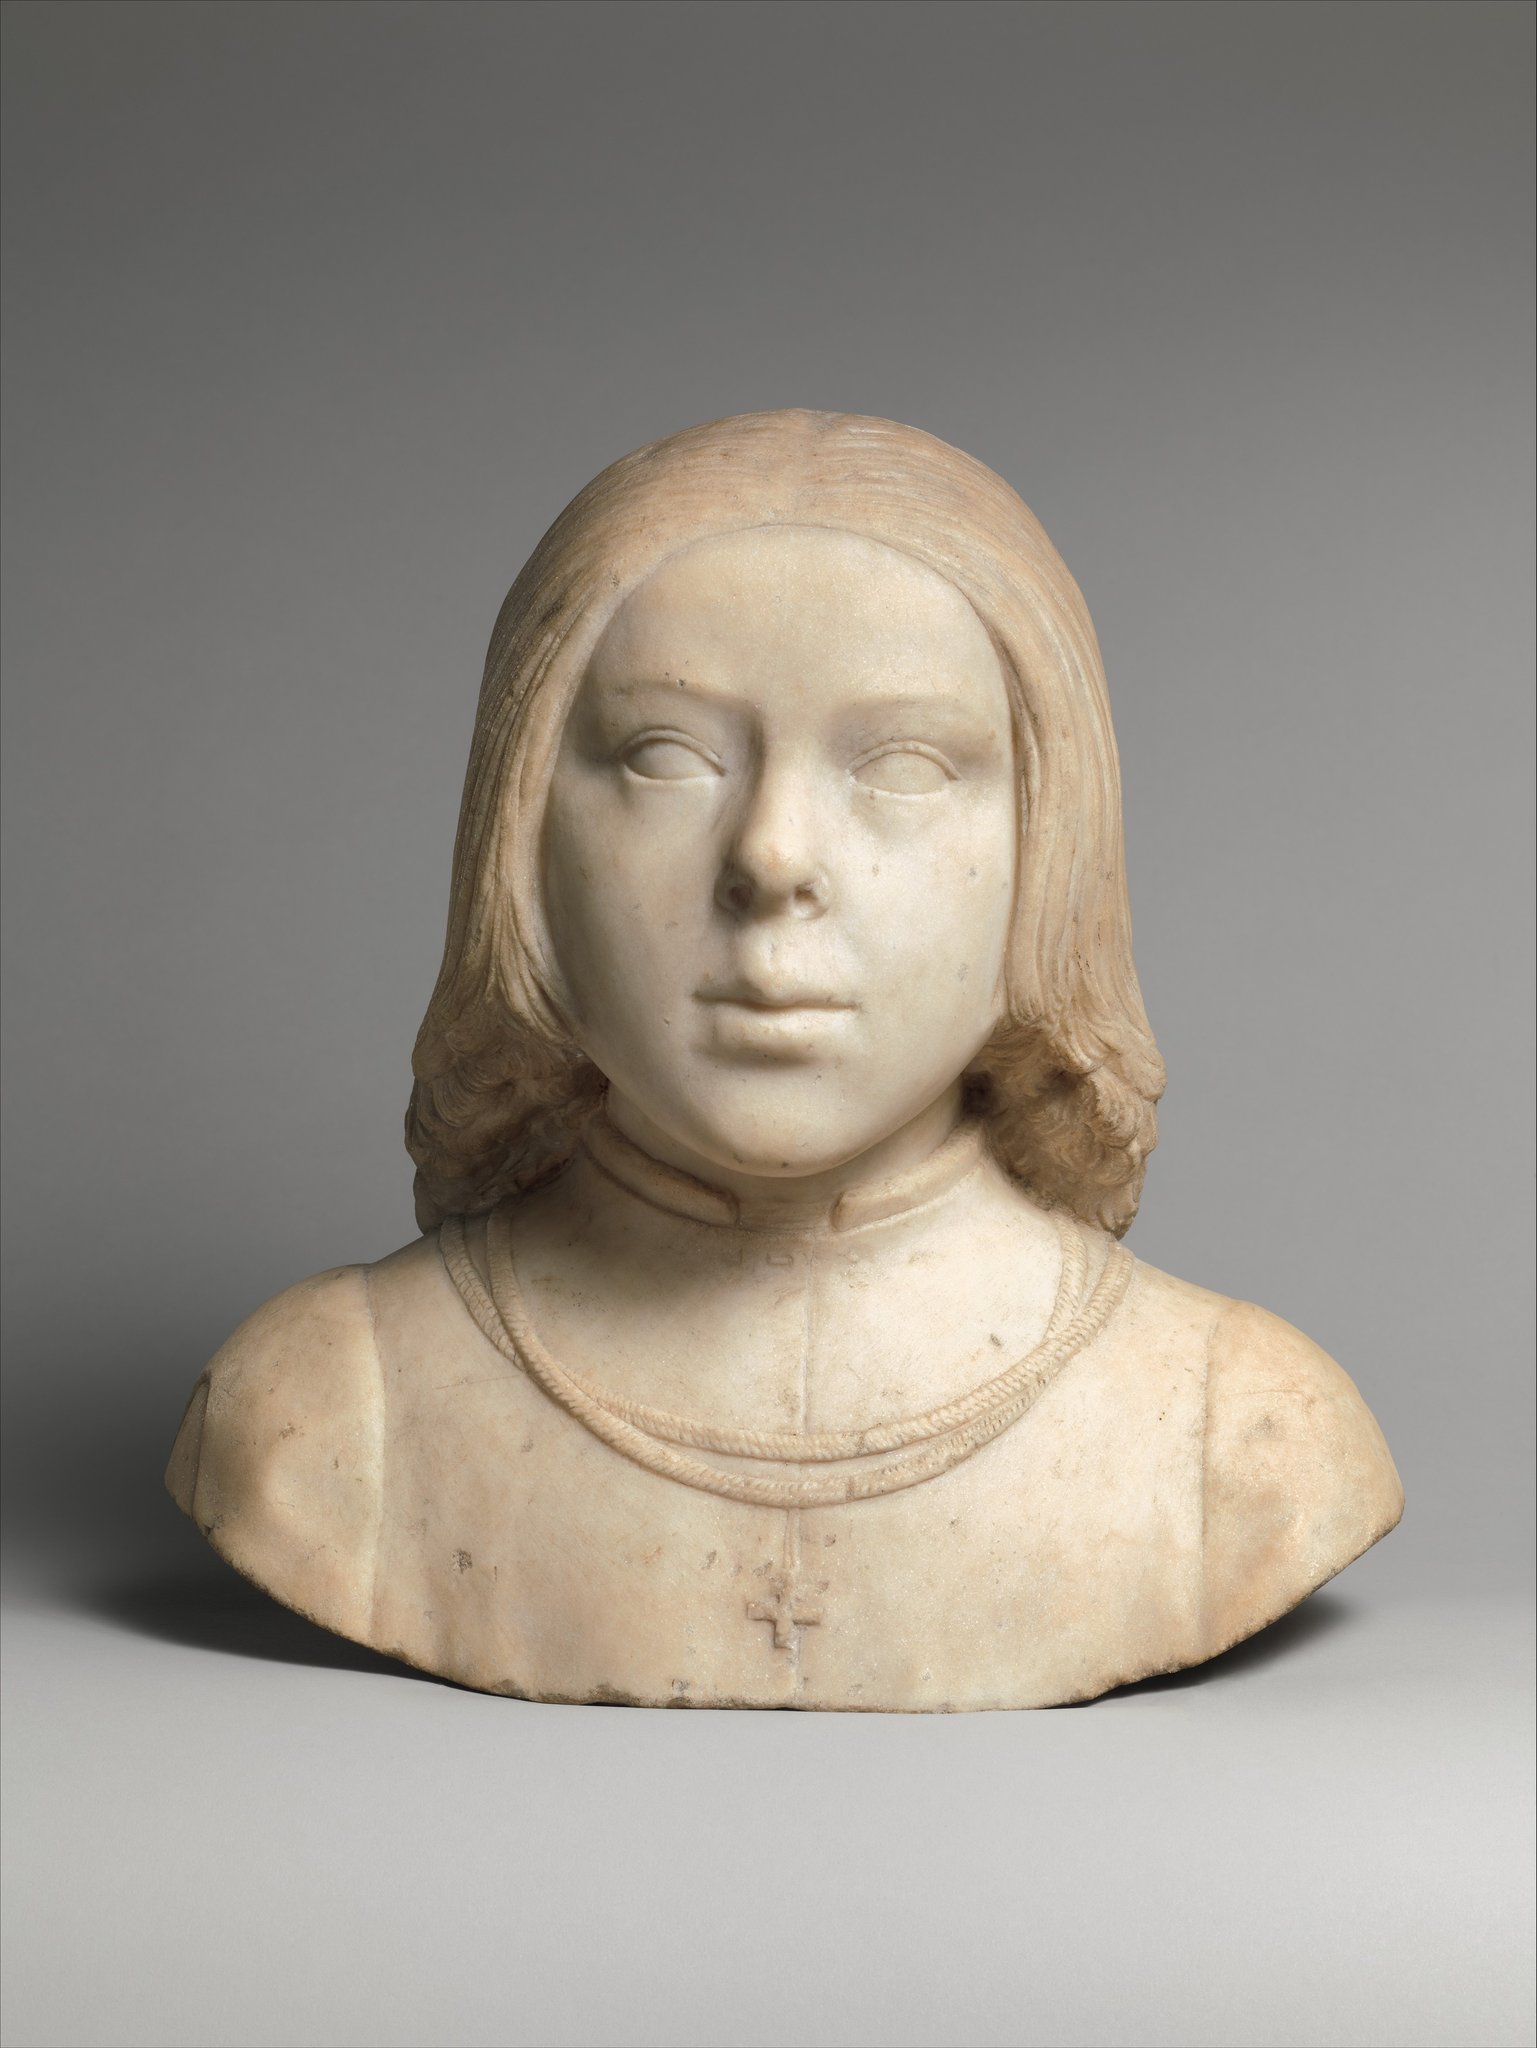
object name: bust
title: A Boy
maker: gian cristoforo romano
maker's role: artist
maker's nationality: italian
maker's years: 1465-1512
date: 1467-1533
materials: marble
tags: boys,cross